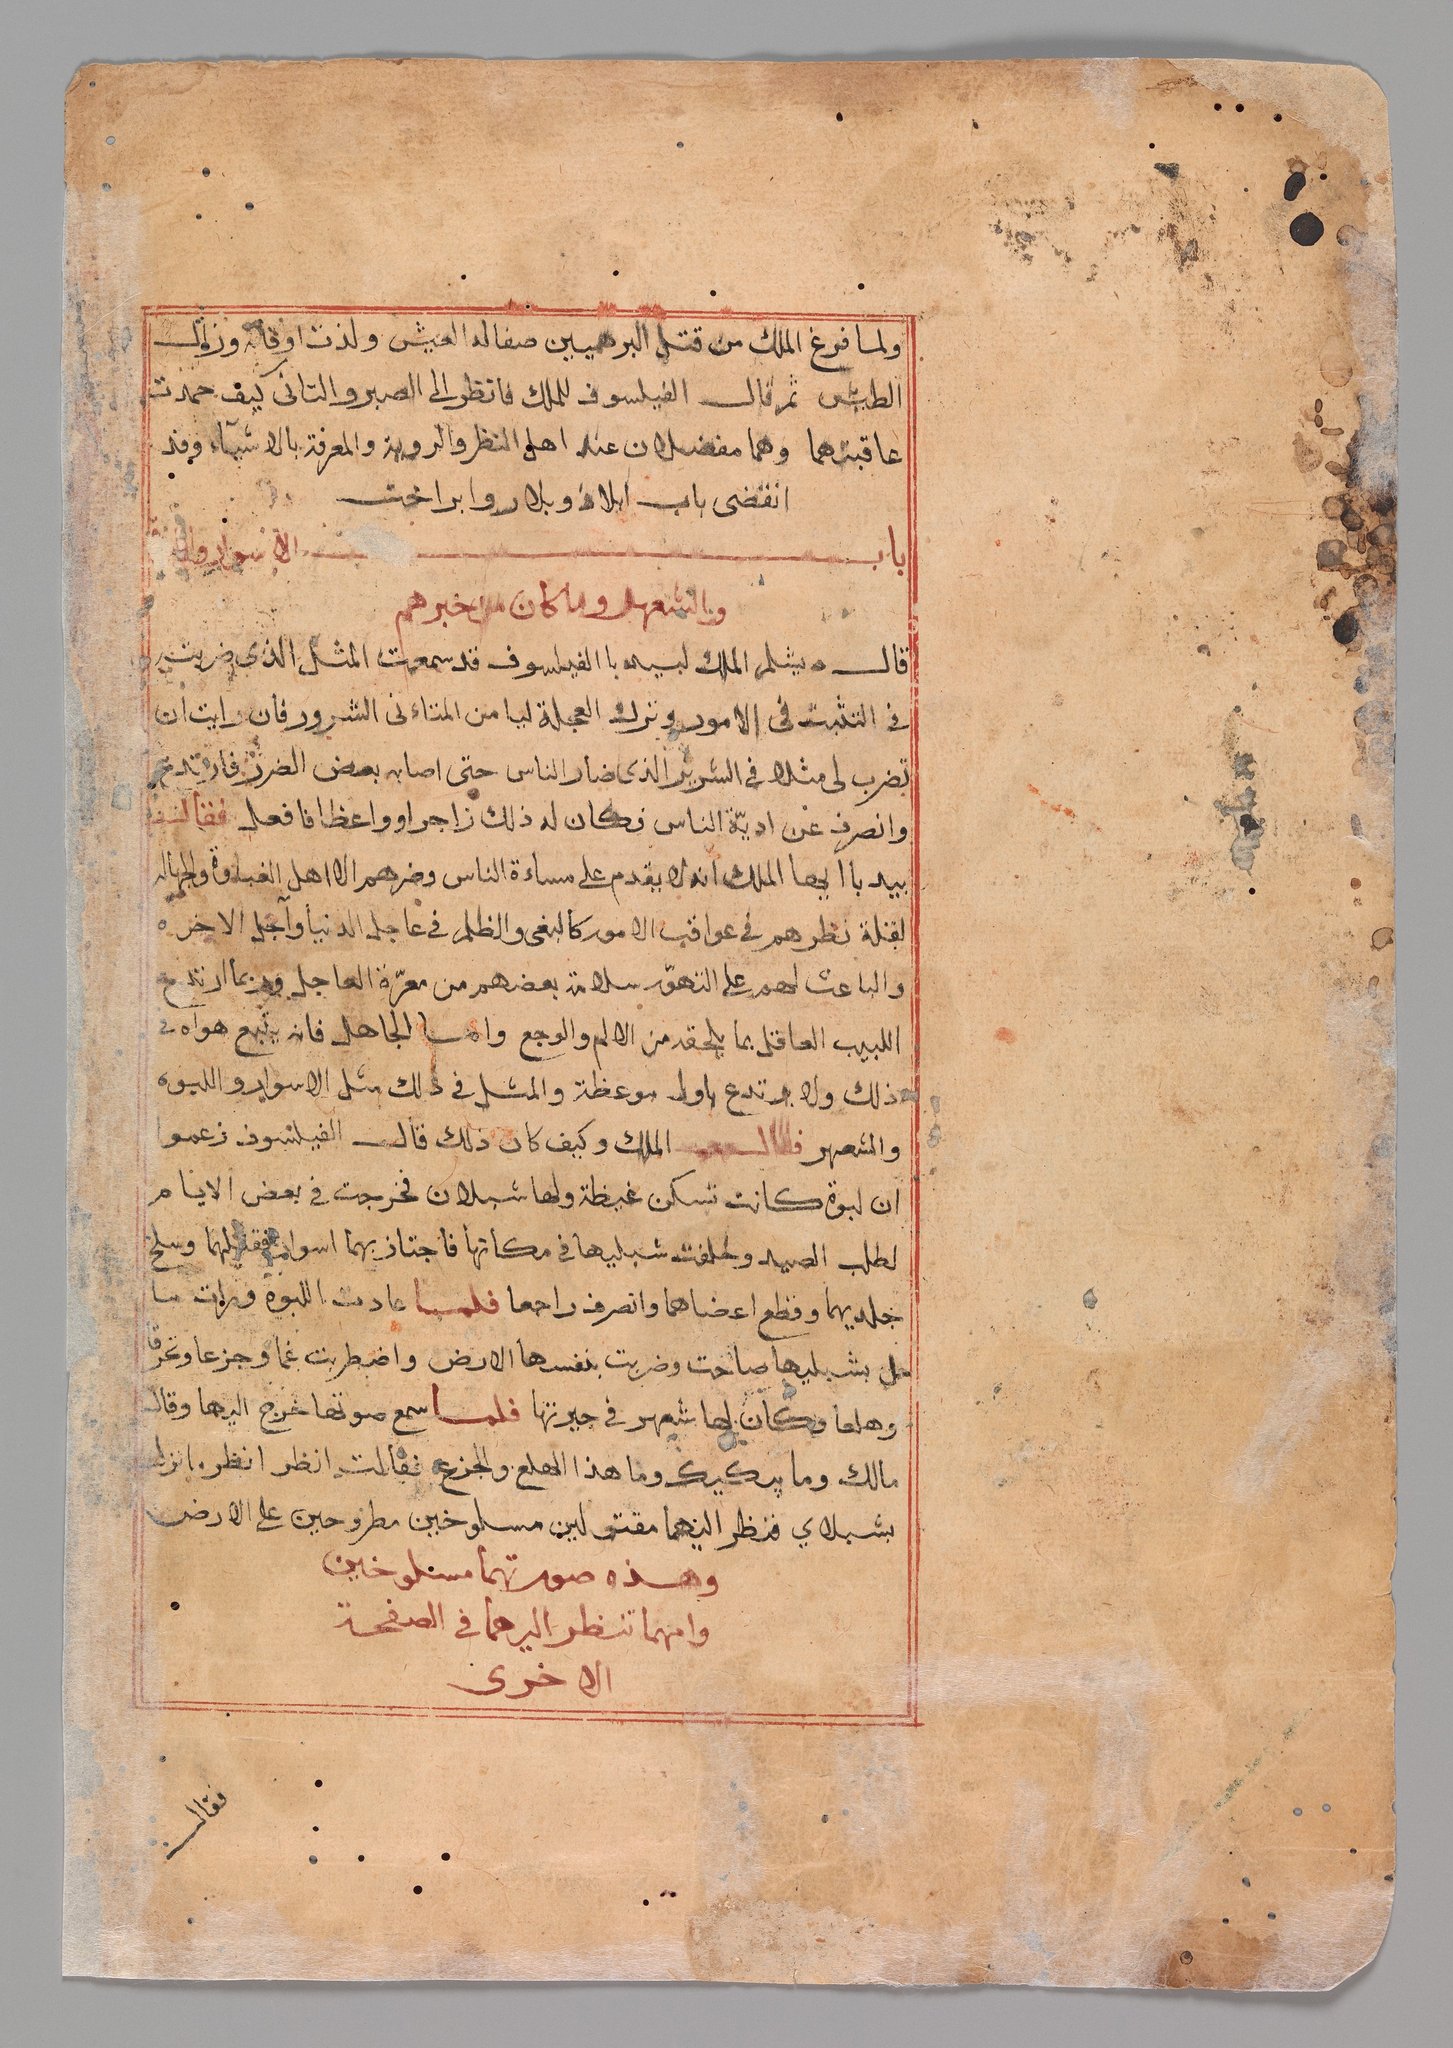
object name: folio from an illustrated manuscript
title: Page of Calligraphy from a Kalila wa Dimna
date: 1526-1550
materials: ink, paper, watercolor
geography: india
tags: arabic,calligraphy